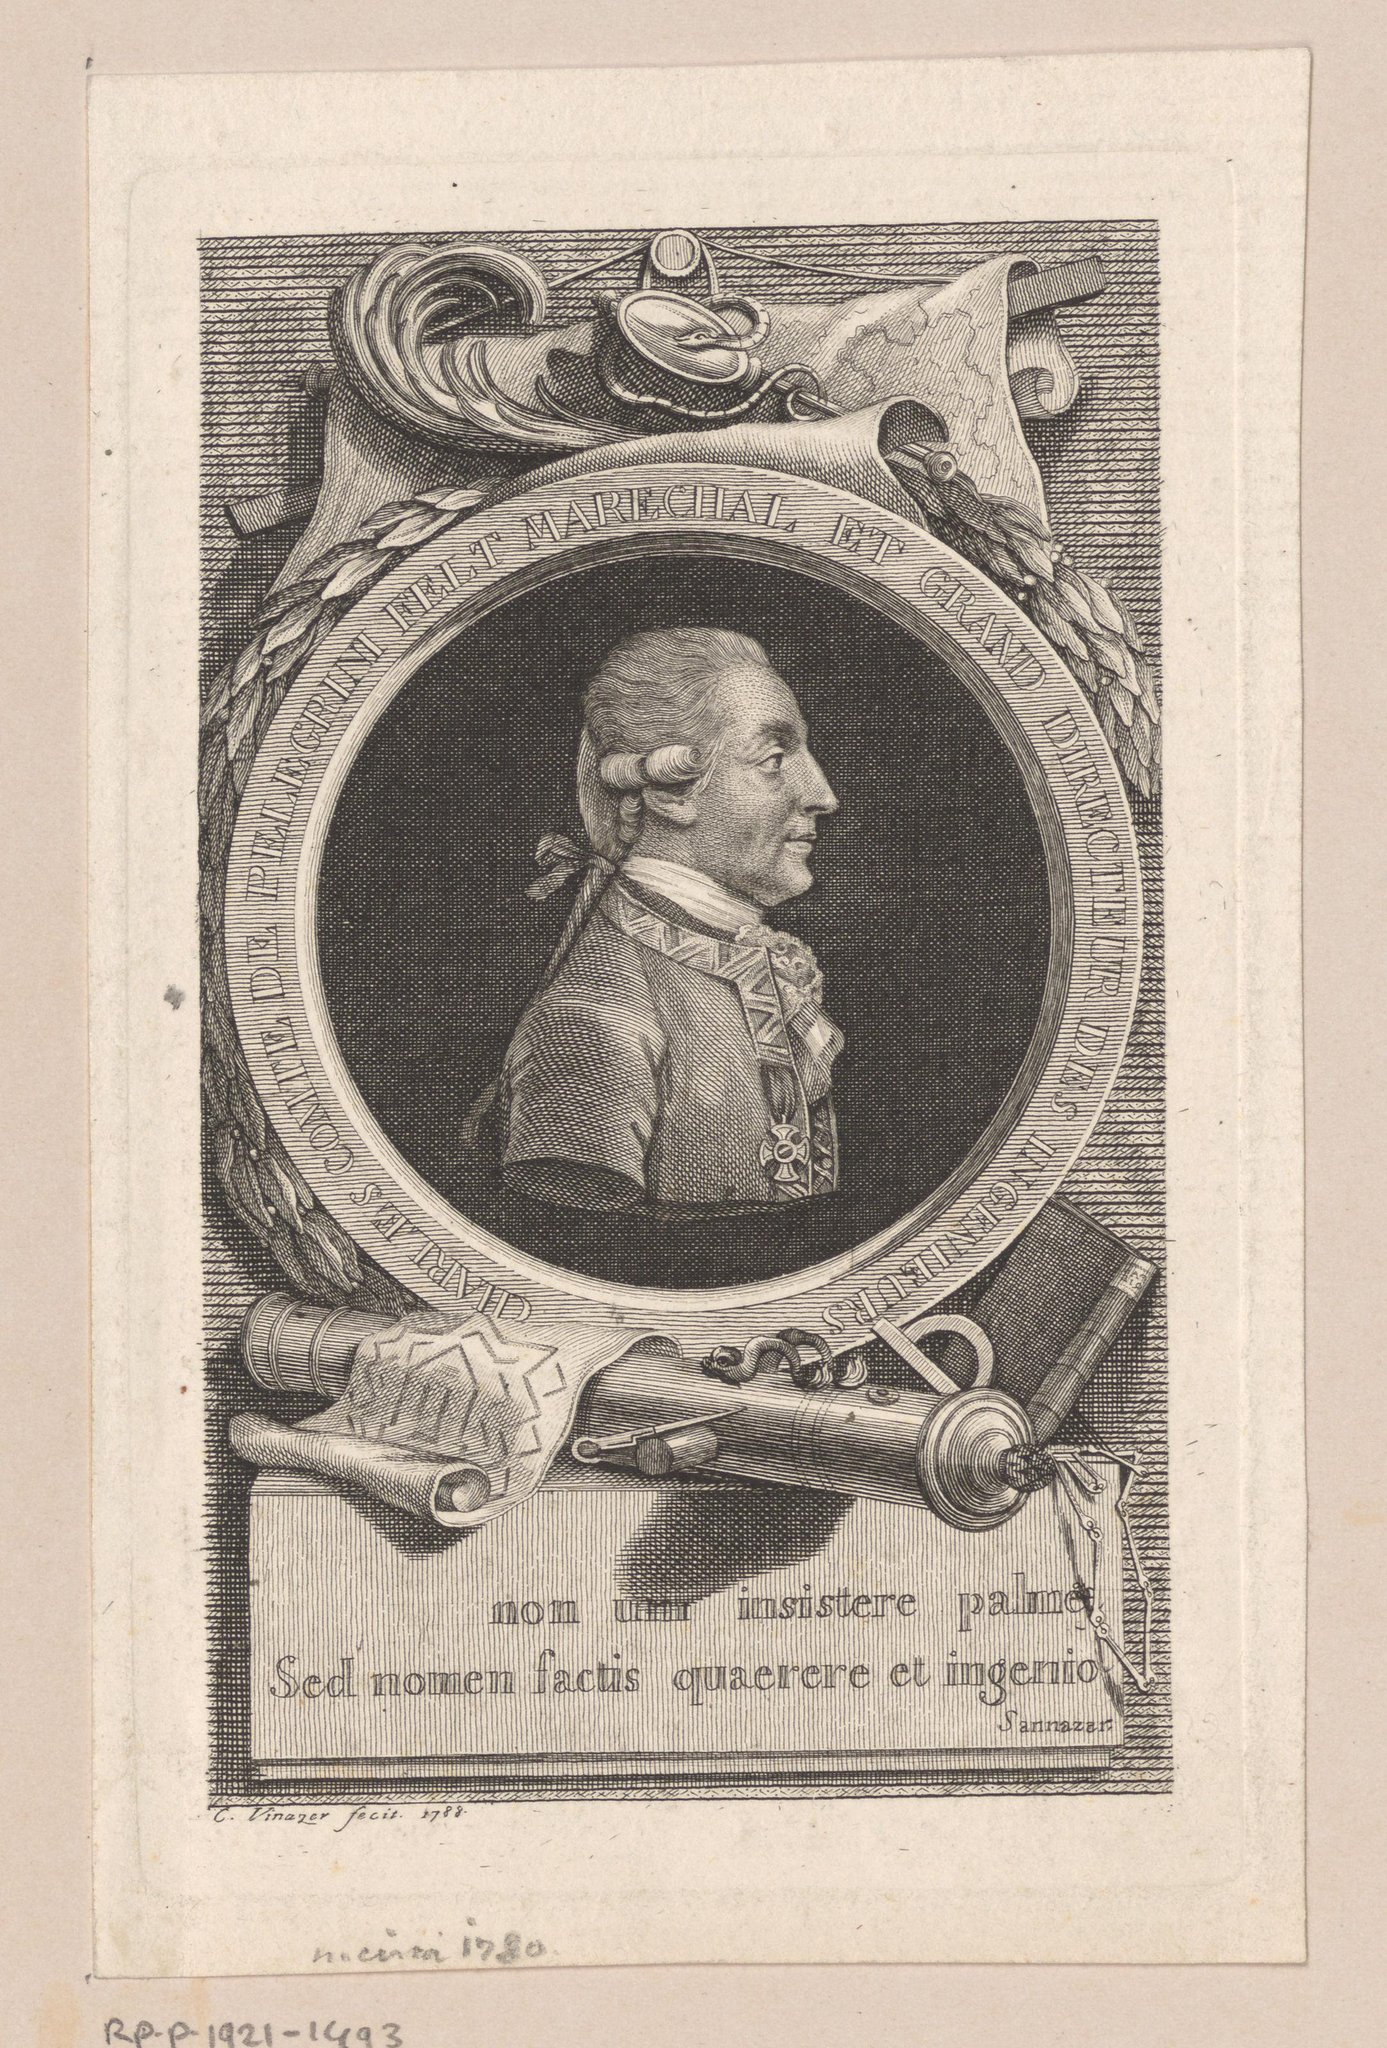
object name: print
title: Portret van Carl Clemens von Pellegrini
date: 1788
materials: paper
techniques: engraving, etching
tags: vienna, adult man, historical persons, weapons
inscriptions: collector's mark: Lugt 2233